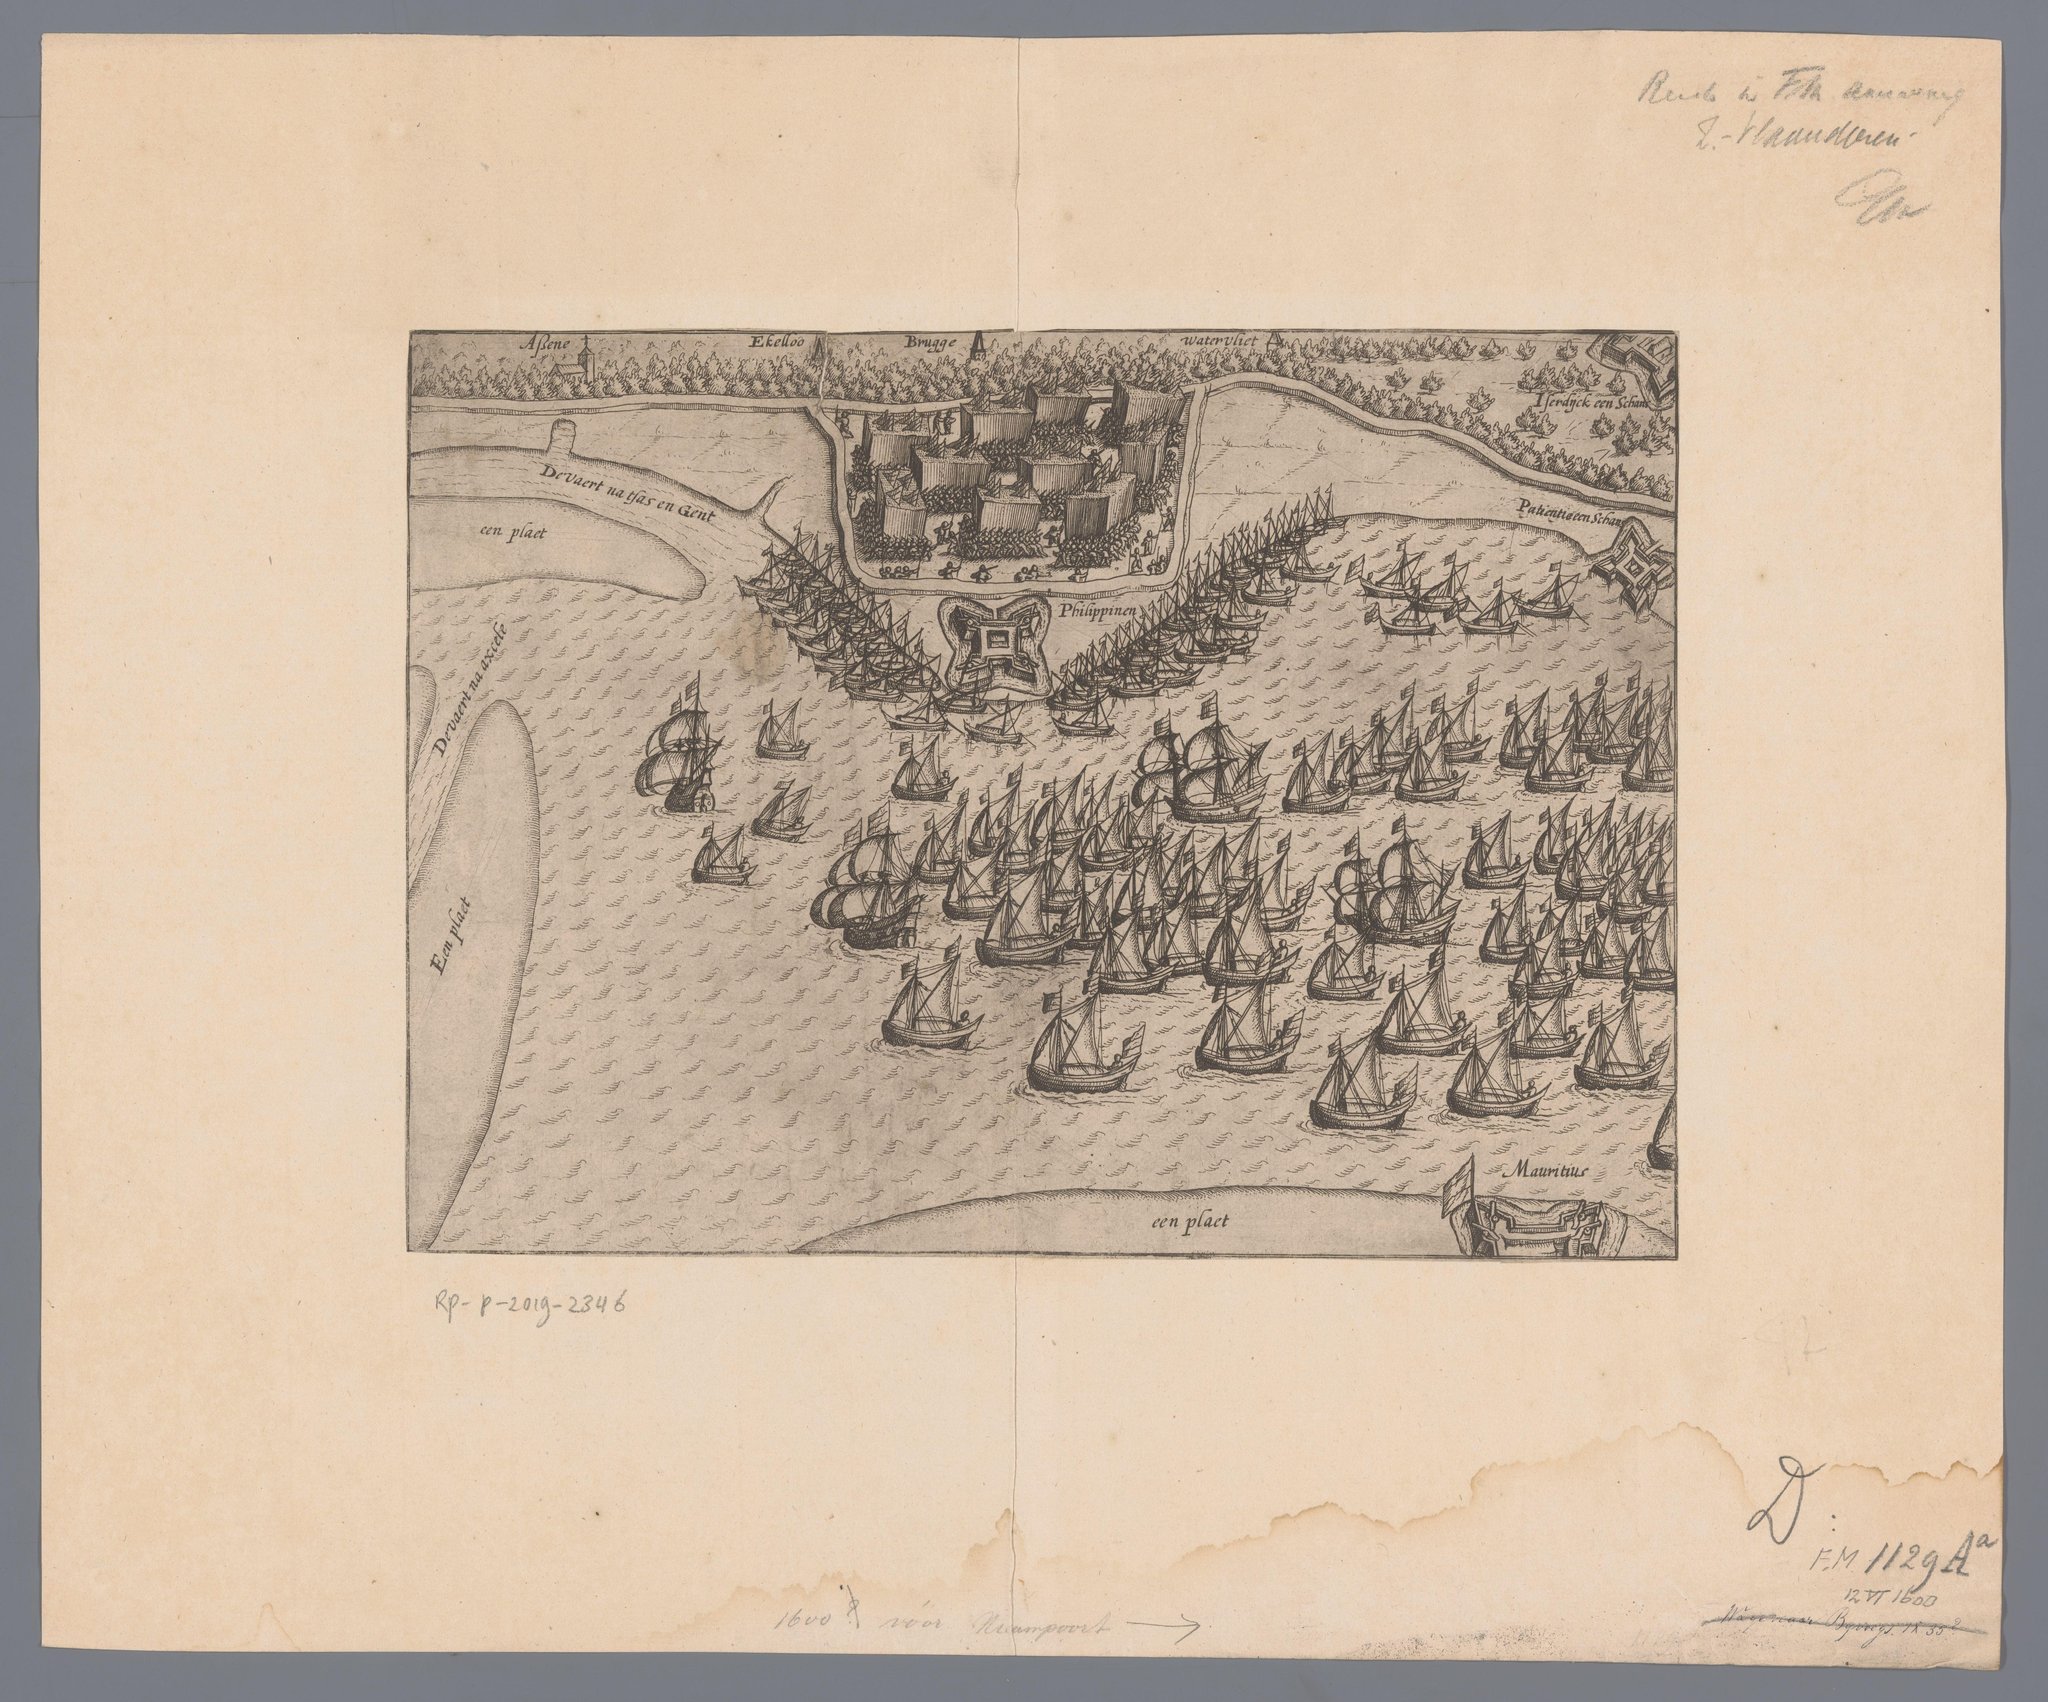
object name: print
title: Staatse vloot voor Philippine, 1600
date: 1600-1602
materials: paper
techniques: etching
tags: maurice (prince of orange), troop movements, transportation (+ sailing-ships), ships (in general) - cc - more than one ship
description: De Staatse vloot van Maurits voor Philippine waar manschappen aan boord worden genomen, 22 juni 1600. Tocht naar Oostende van het Staatse leger, 19-27 juni, 1600.